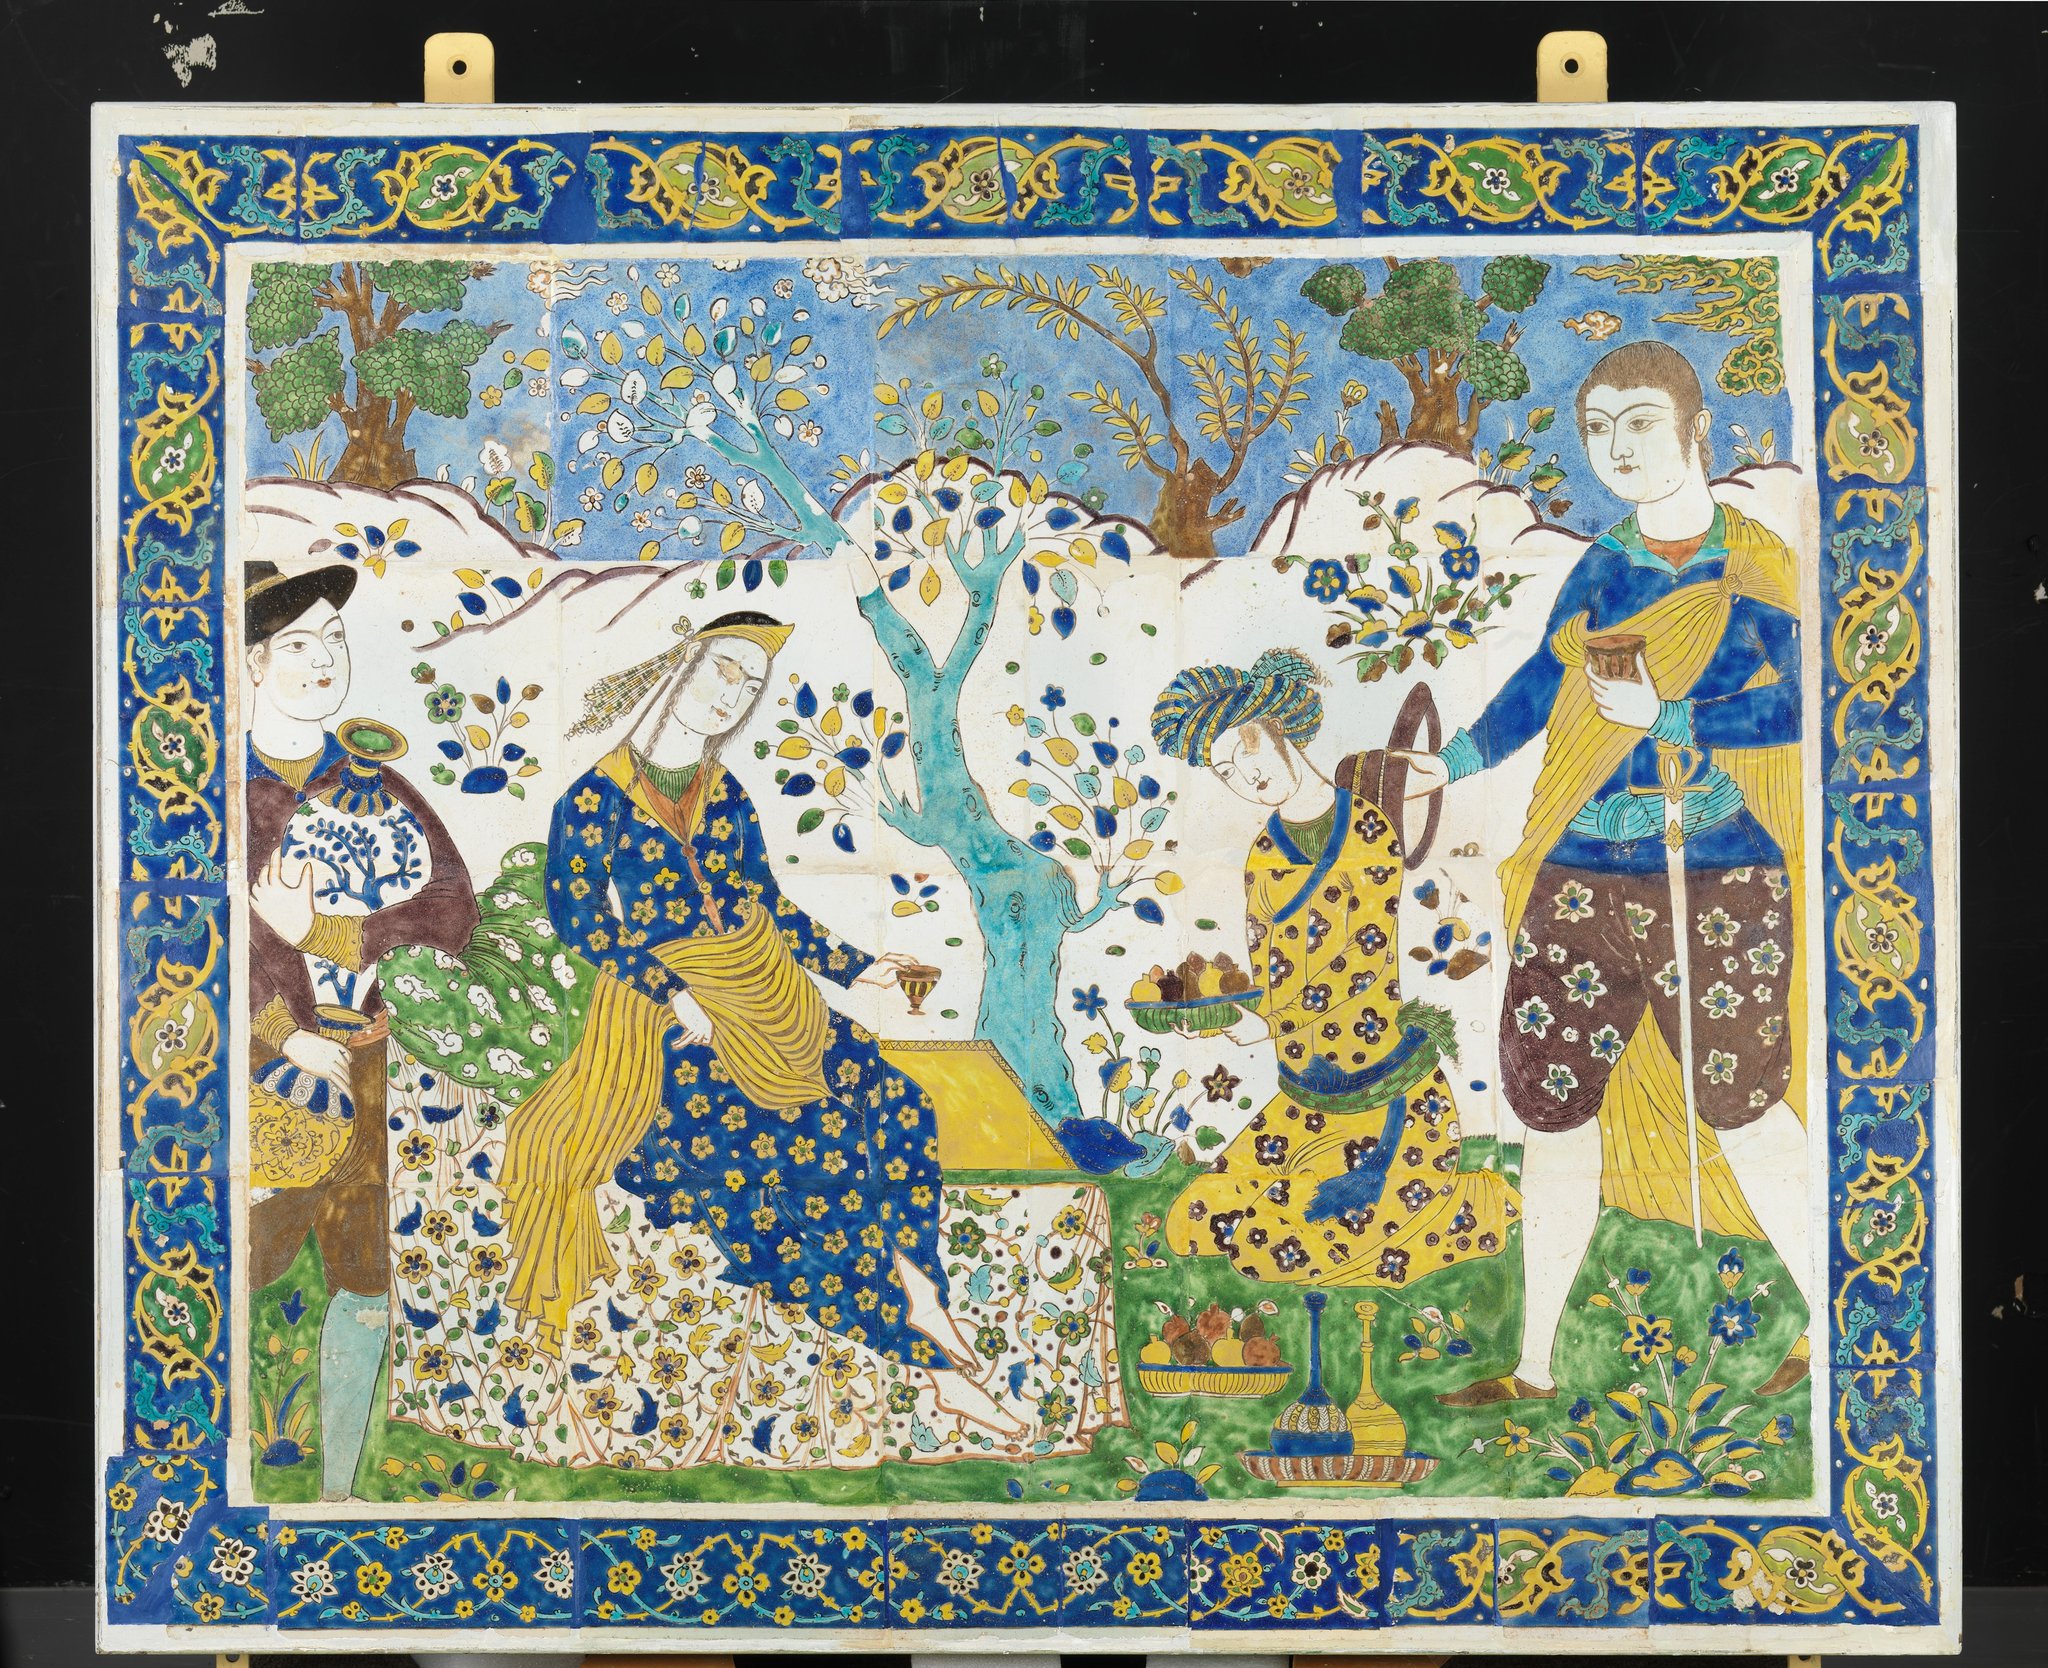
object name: tile panel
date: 1601-1625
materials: stonepaste, wax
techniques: glazing, polychrome, resist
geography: iran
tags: men,women,flowers,trees